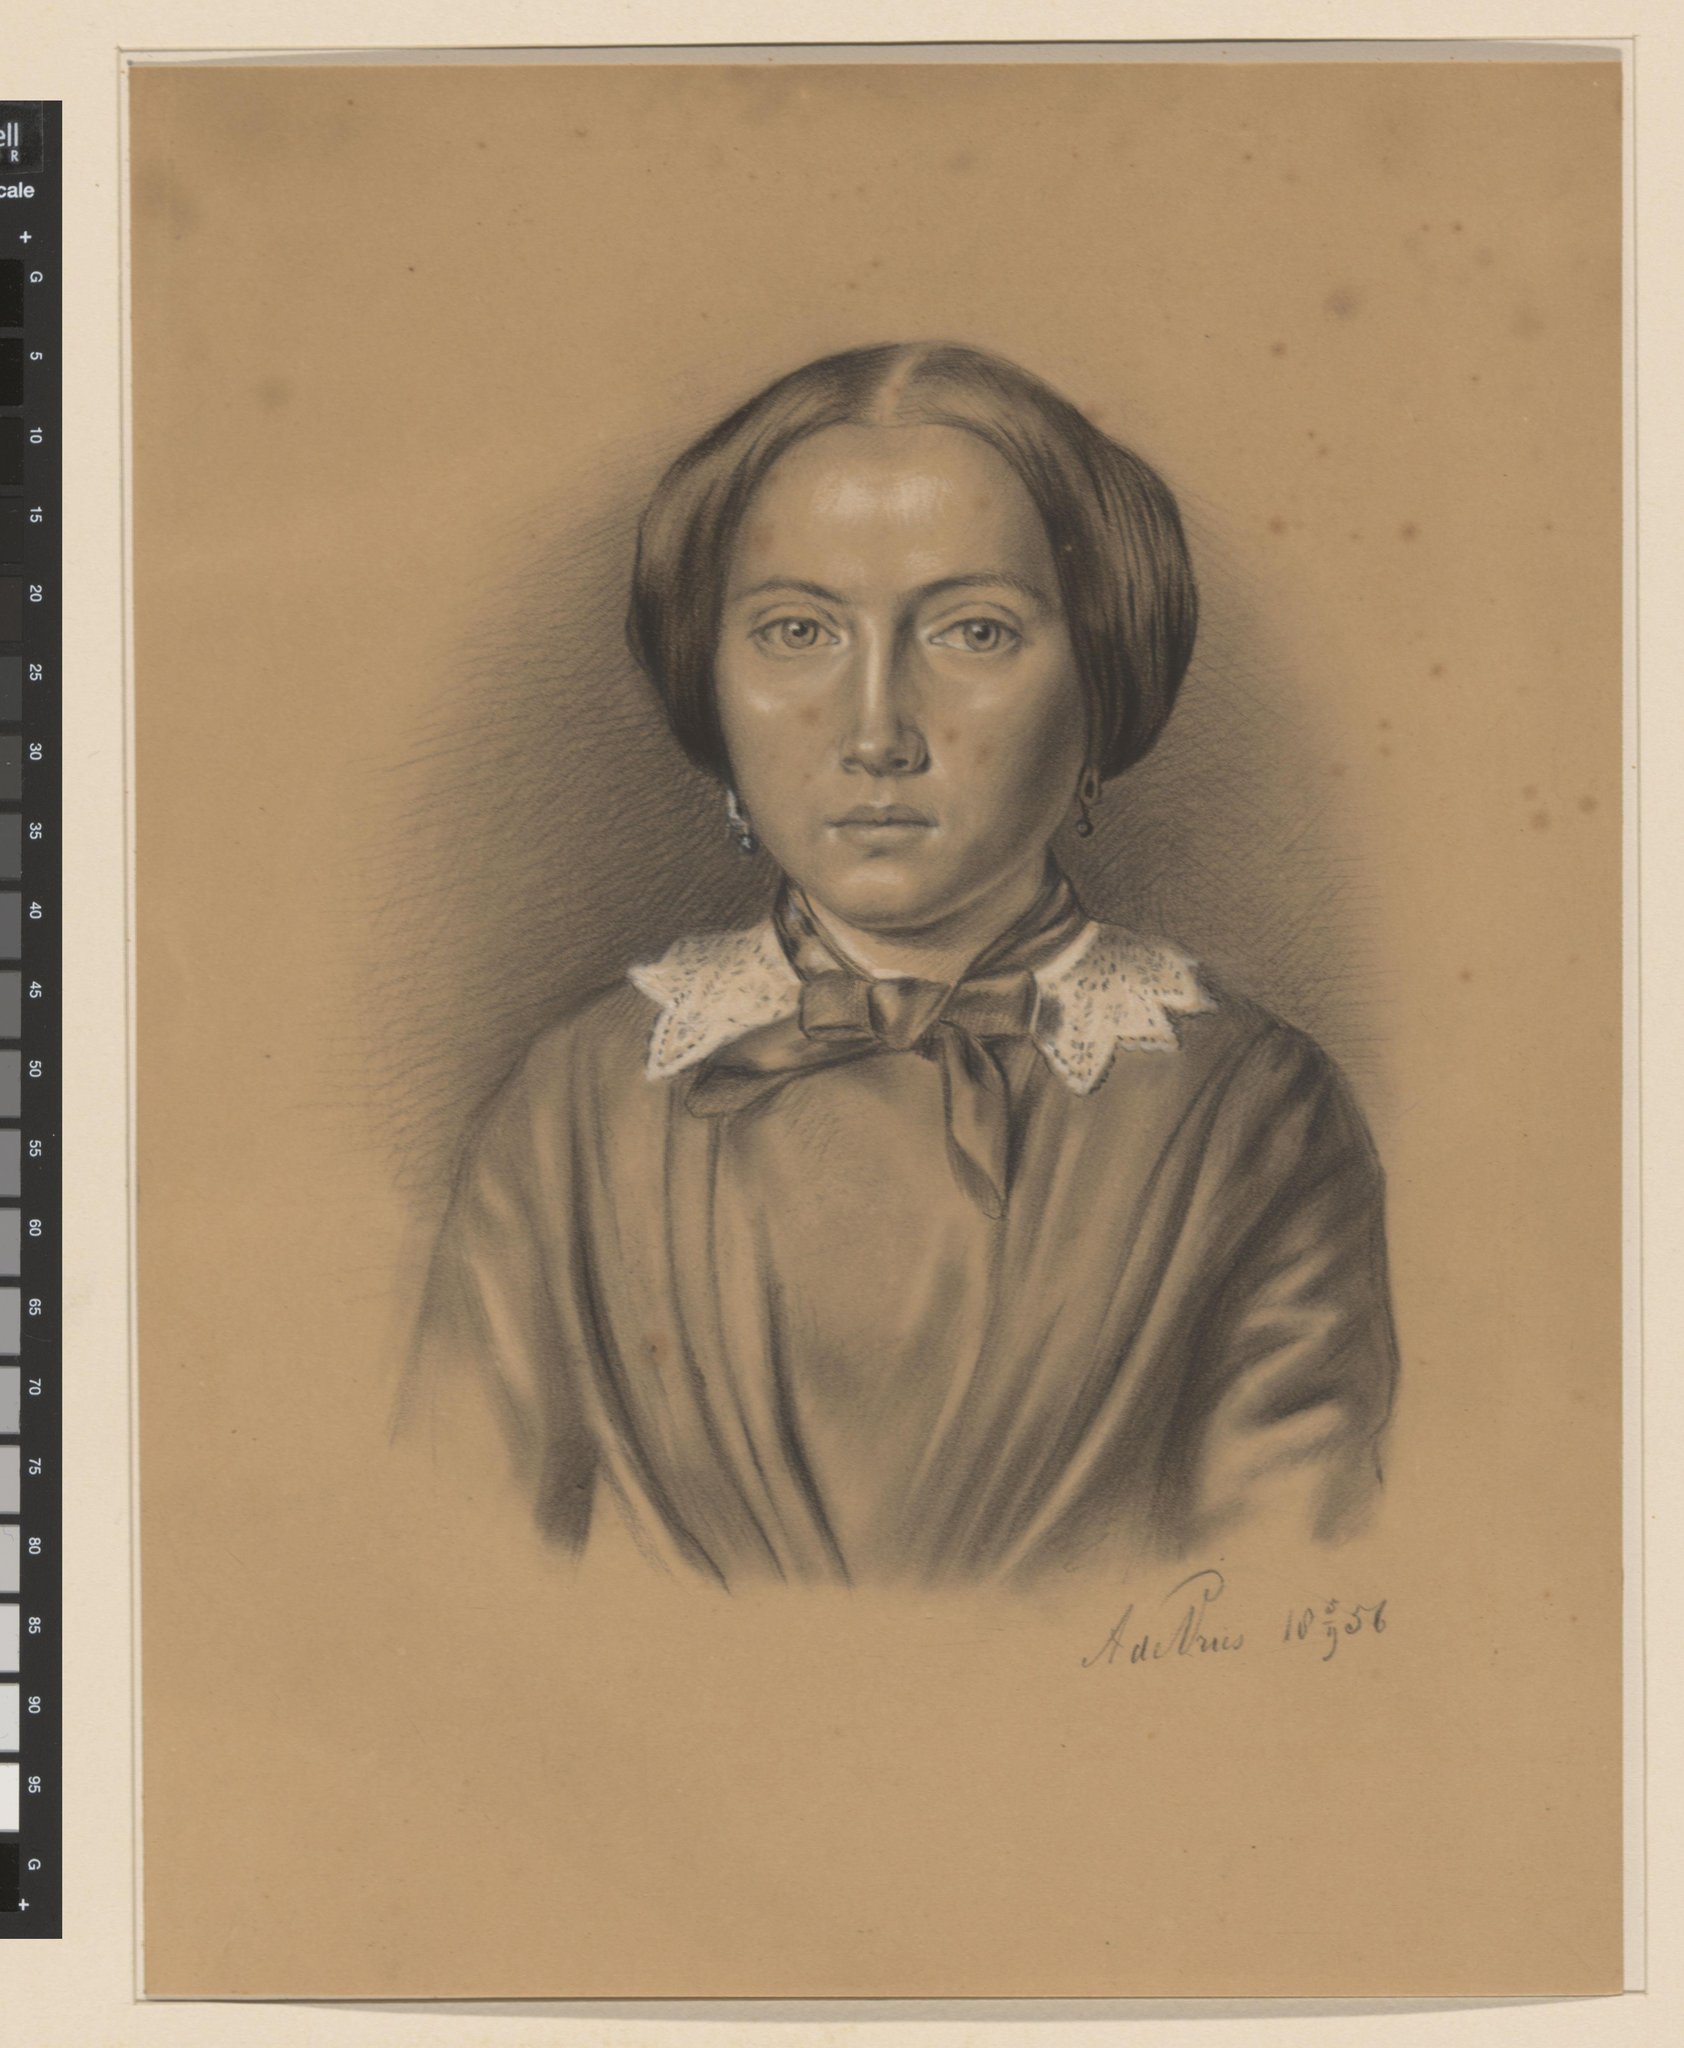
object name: drawing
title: Portret van Gueltje de Vries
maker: anthony de vries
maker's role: draughtsman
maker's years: 1841-1872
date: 1856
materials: chalk, paper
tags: historical persons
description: Portret van Gueltje de Vries, zuster van de tekenaar.